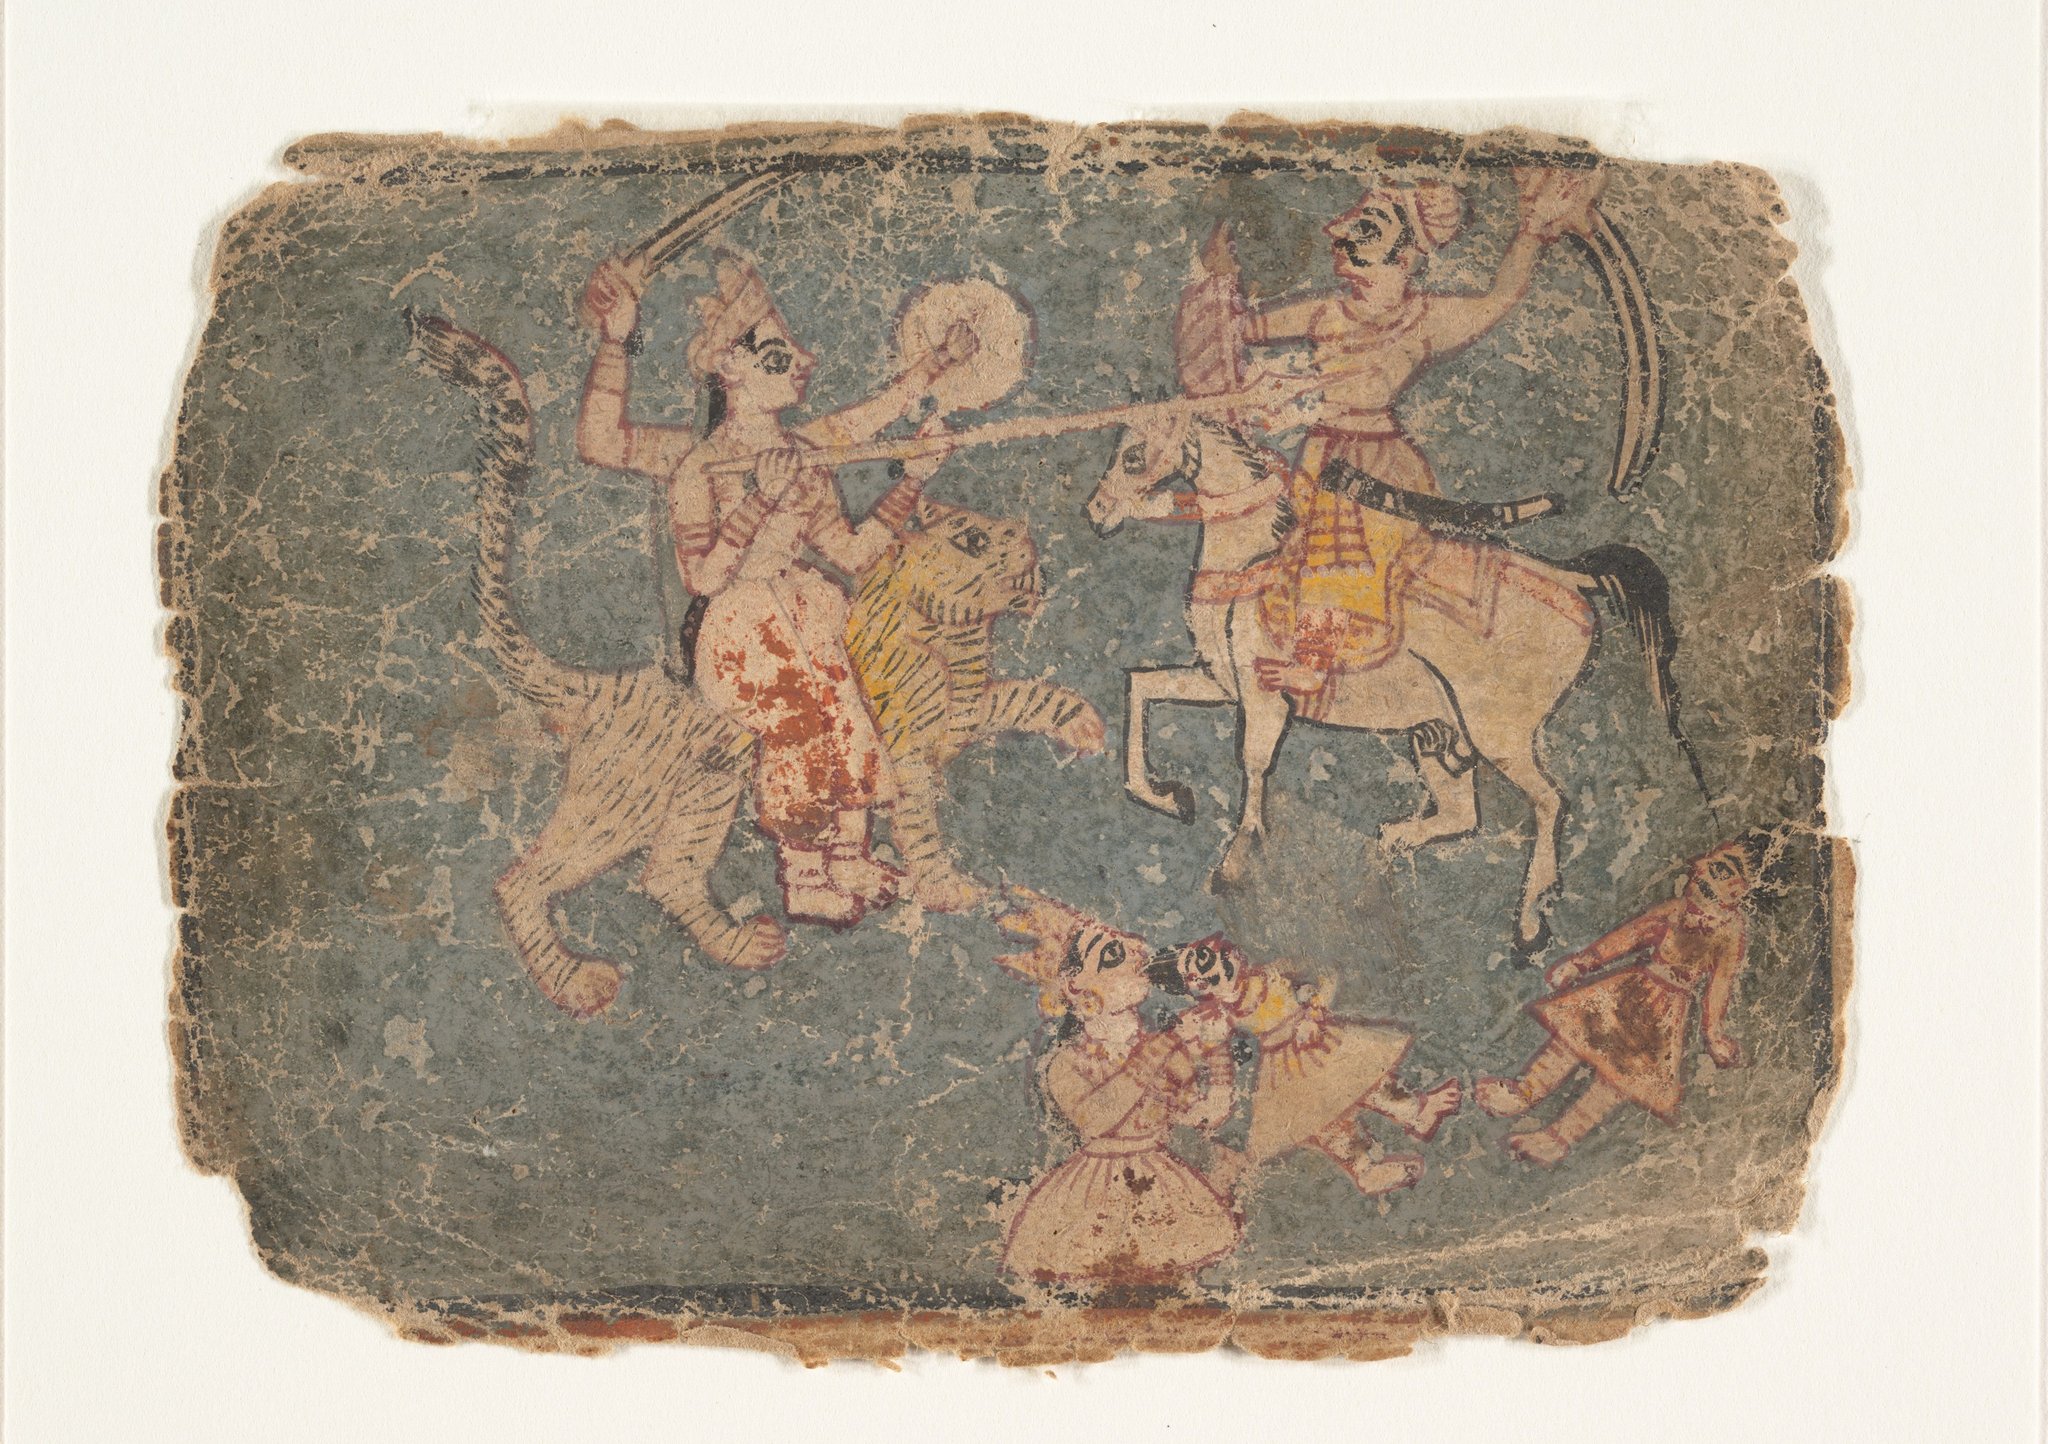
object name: folio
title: The Goddess Durga Slaying an Enemy; Page from a Dispersed Markandeya Purana (Stories of the Sage Markandeya)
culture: indian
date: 1650-1660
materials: ink, paper, watercolor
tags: men,horses,tigers,durga